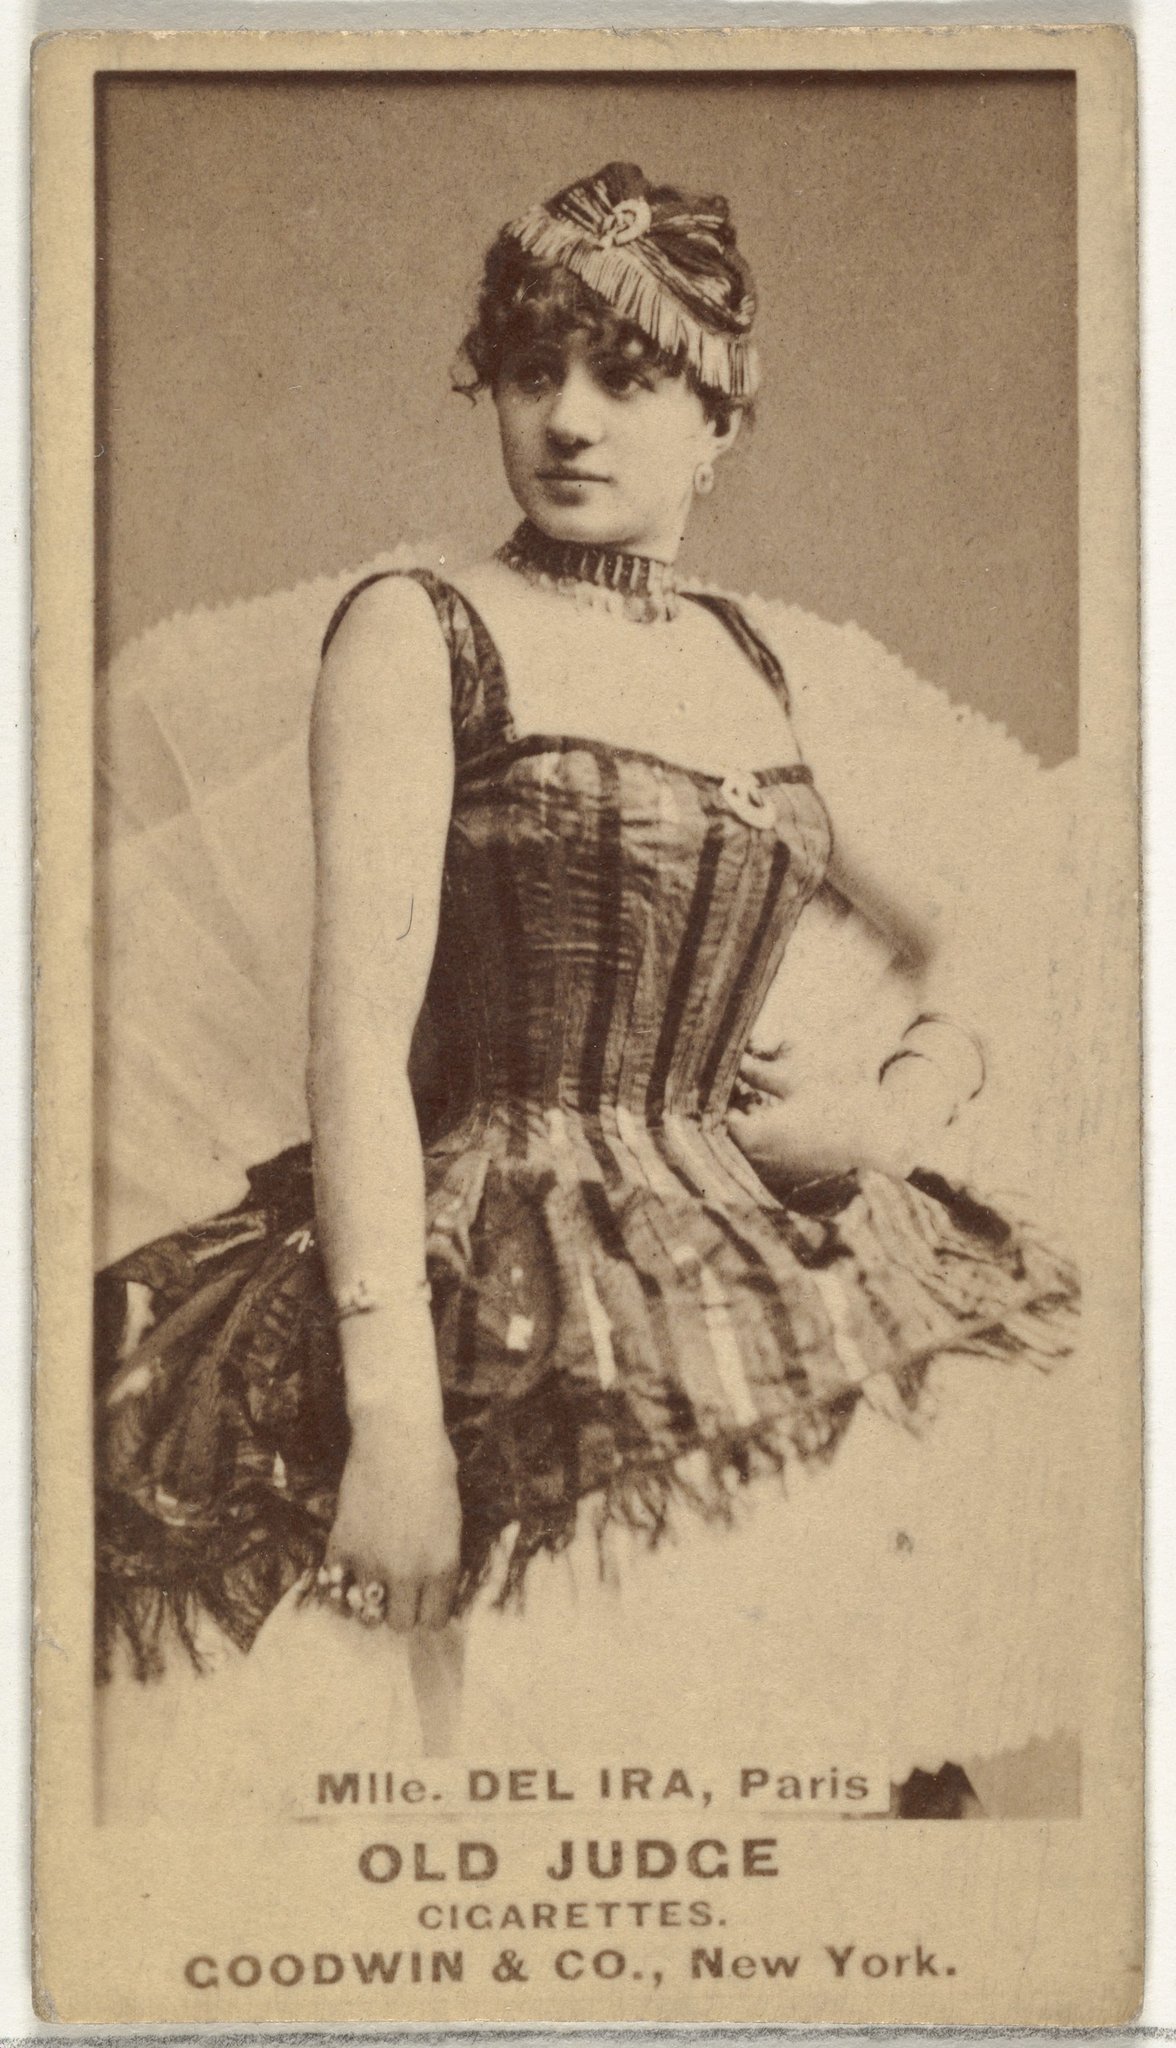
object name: photograph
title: Mlle. Del Ira, Paris, from the Actors and Actresses series (N171) for Old Judge Cigarettes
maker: goodwin & company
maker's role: publisher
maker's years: 1850-1950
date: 1886-1890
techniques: albumen silver print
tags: portraits,women,actresses